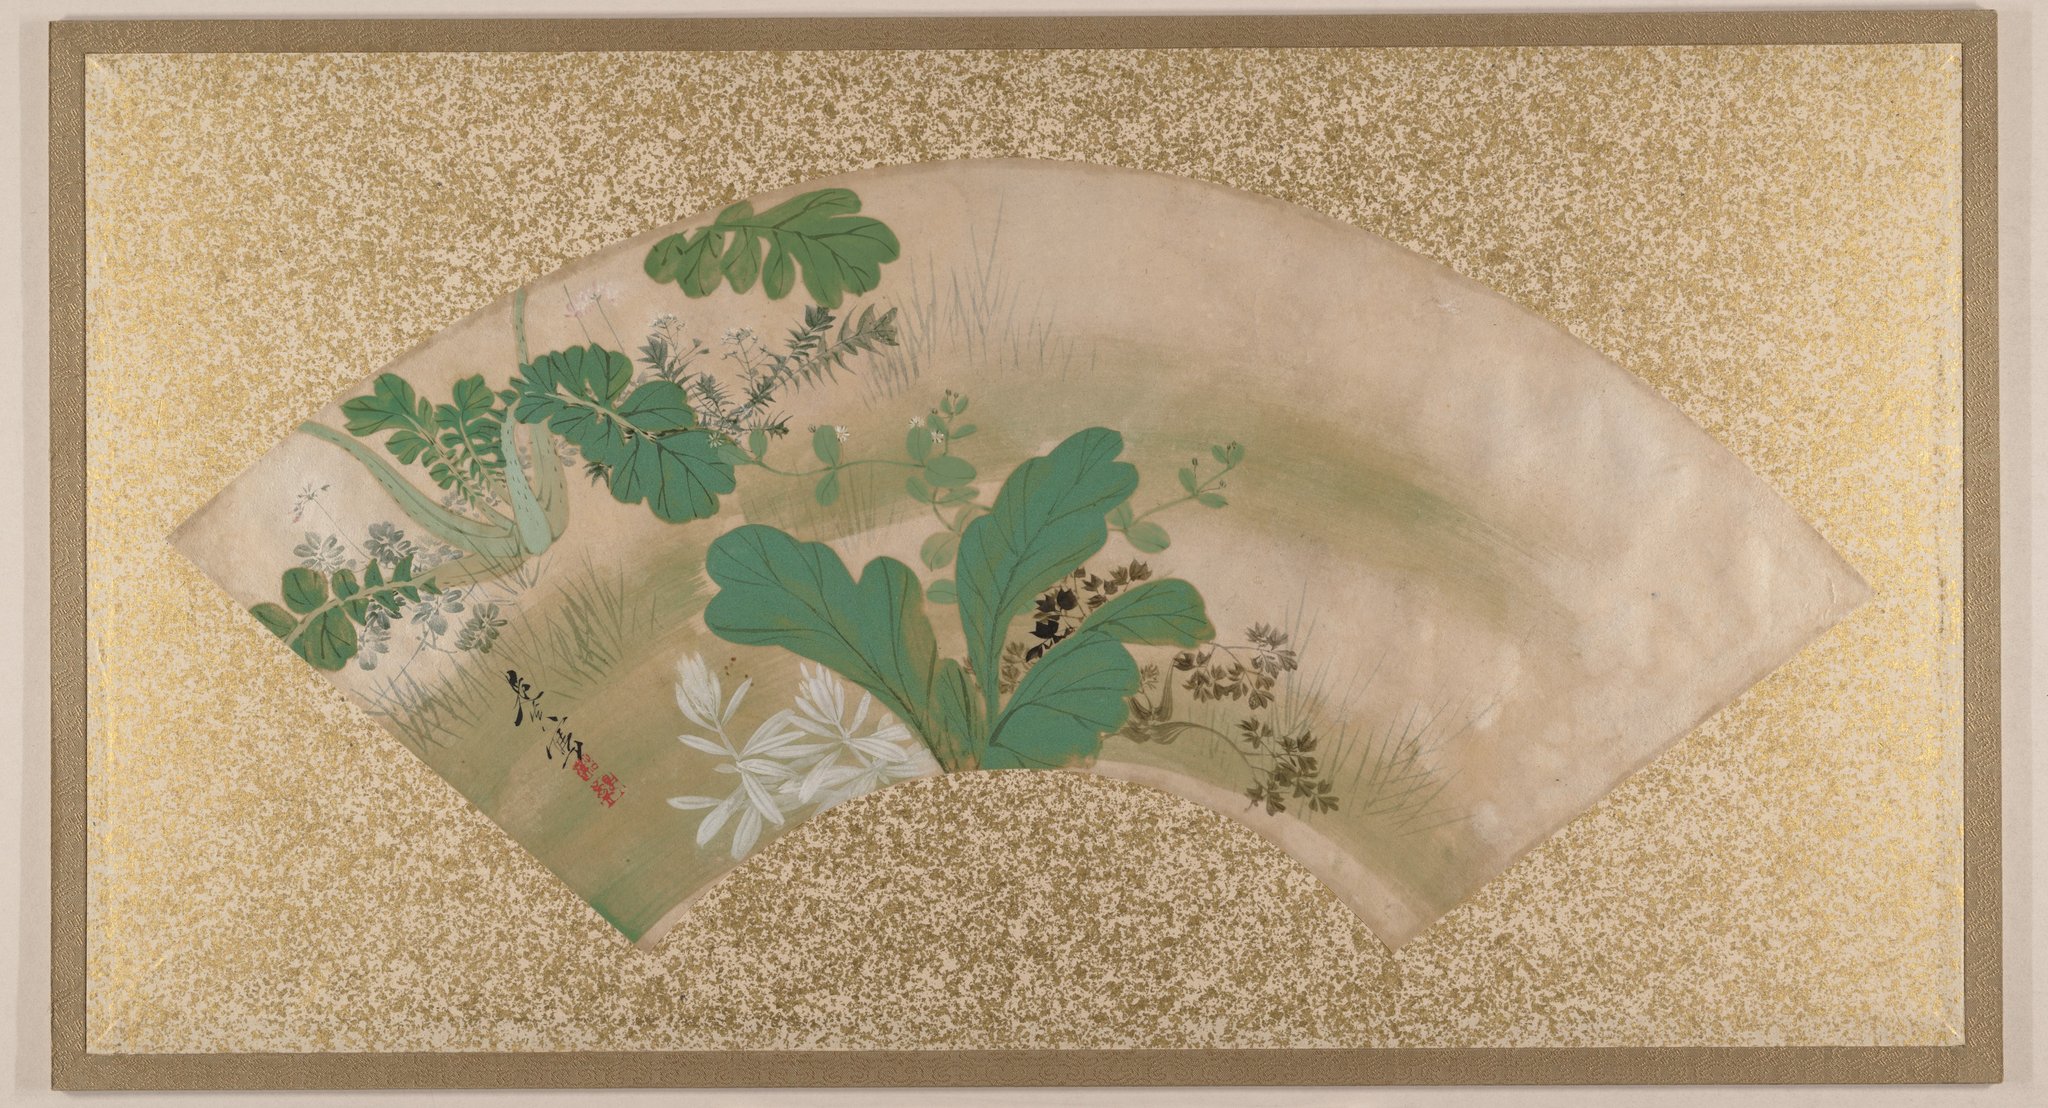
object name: album leaf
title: Various Plants and Grass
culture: japanese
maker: shibata zeshin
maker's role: artist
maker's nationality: japanese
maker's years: 1807-1891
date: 1867-1900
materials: paper, paint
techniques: painting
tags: plants